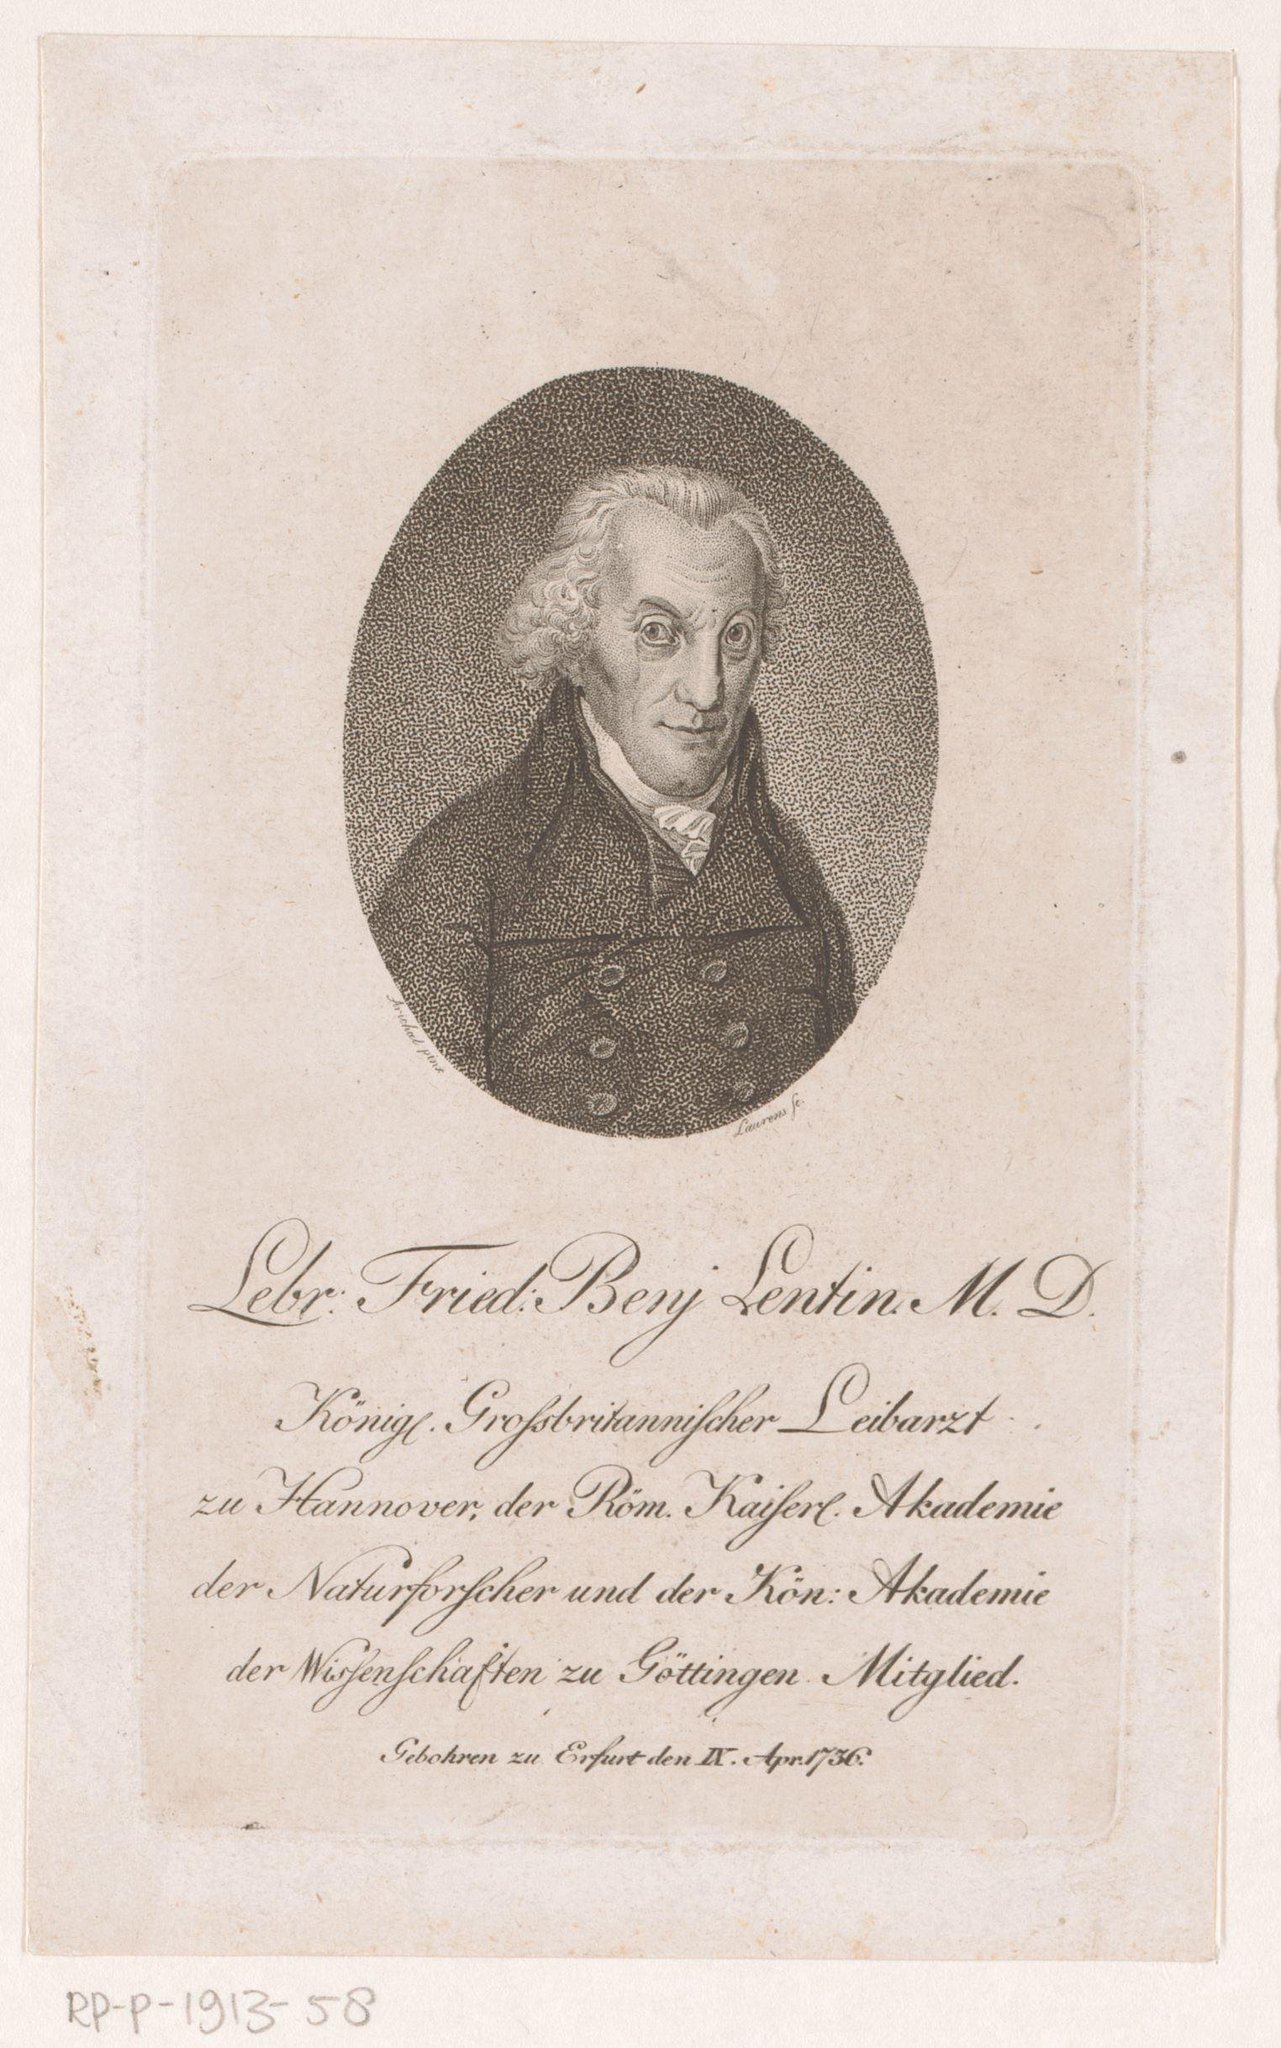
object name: print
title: Portret van Lebrecht Friedrich Benjamin Lentin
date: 1780-1832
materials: paper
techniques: etching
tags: historical persons, physician, doctor (+ portrait of scholar, scientist)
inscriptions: collector's mark: Lugt 2228